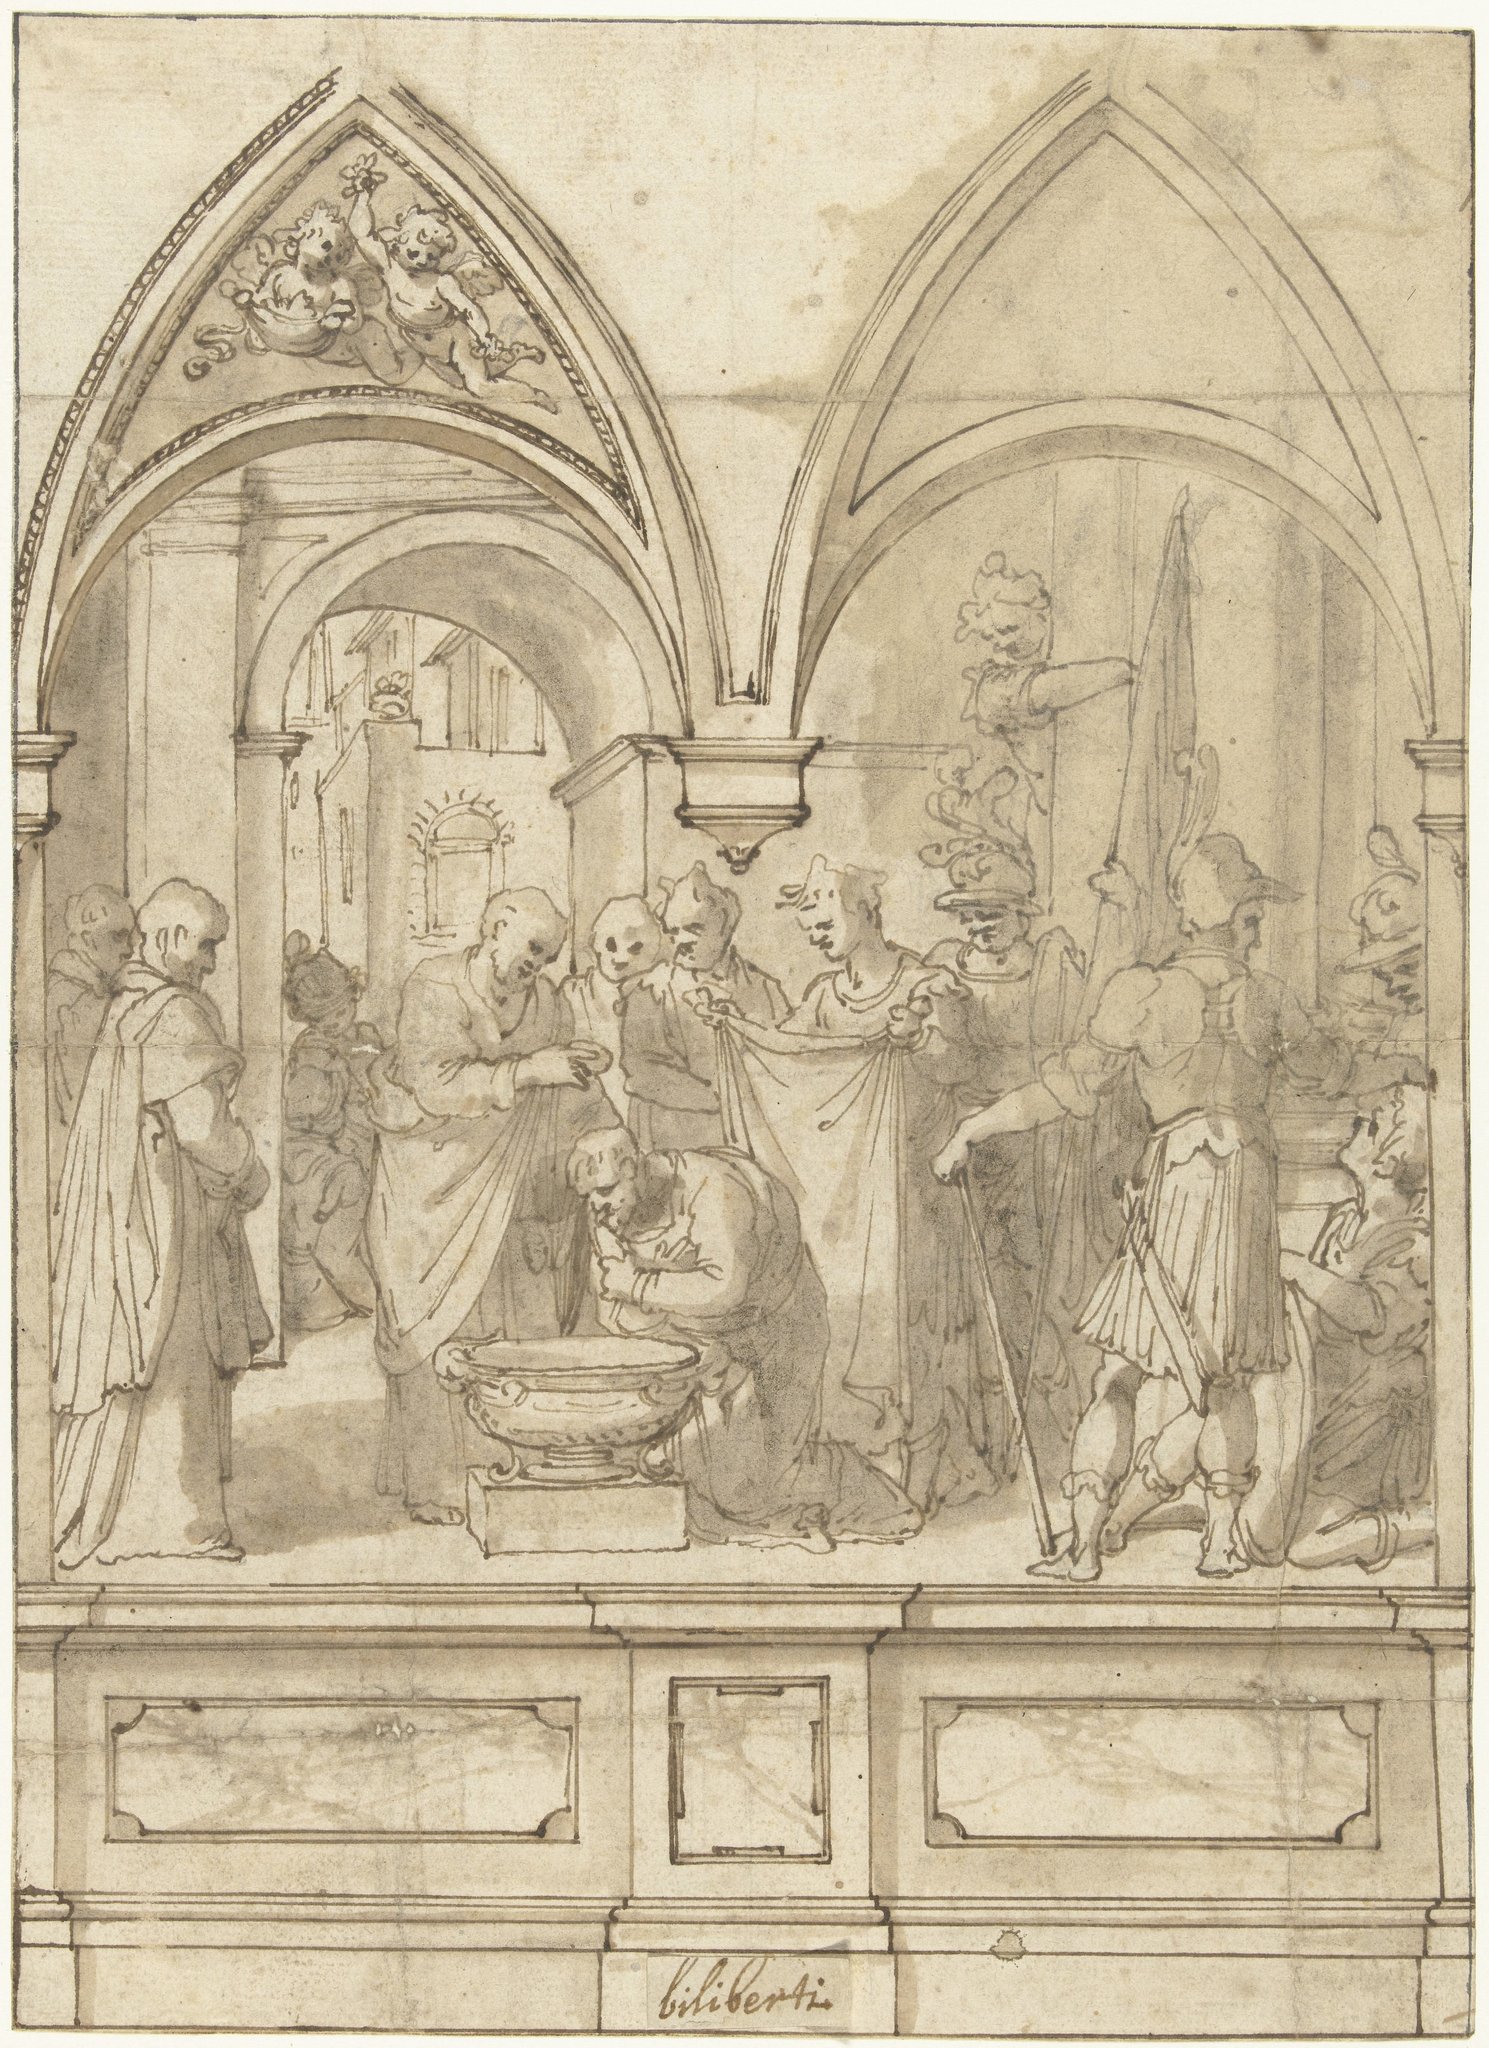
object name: drawing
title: De doop van de centurio, door Petrus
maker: giovanni bilivert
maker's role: painter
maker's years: 1585-1644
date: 1604-1607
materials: chalk, ink, paper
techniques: brush, pen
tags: peter in the house of cornelius: the holy ghost descends upon cornelius and his family, who are baptized by peter